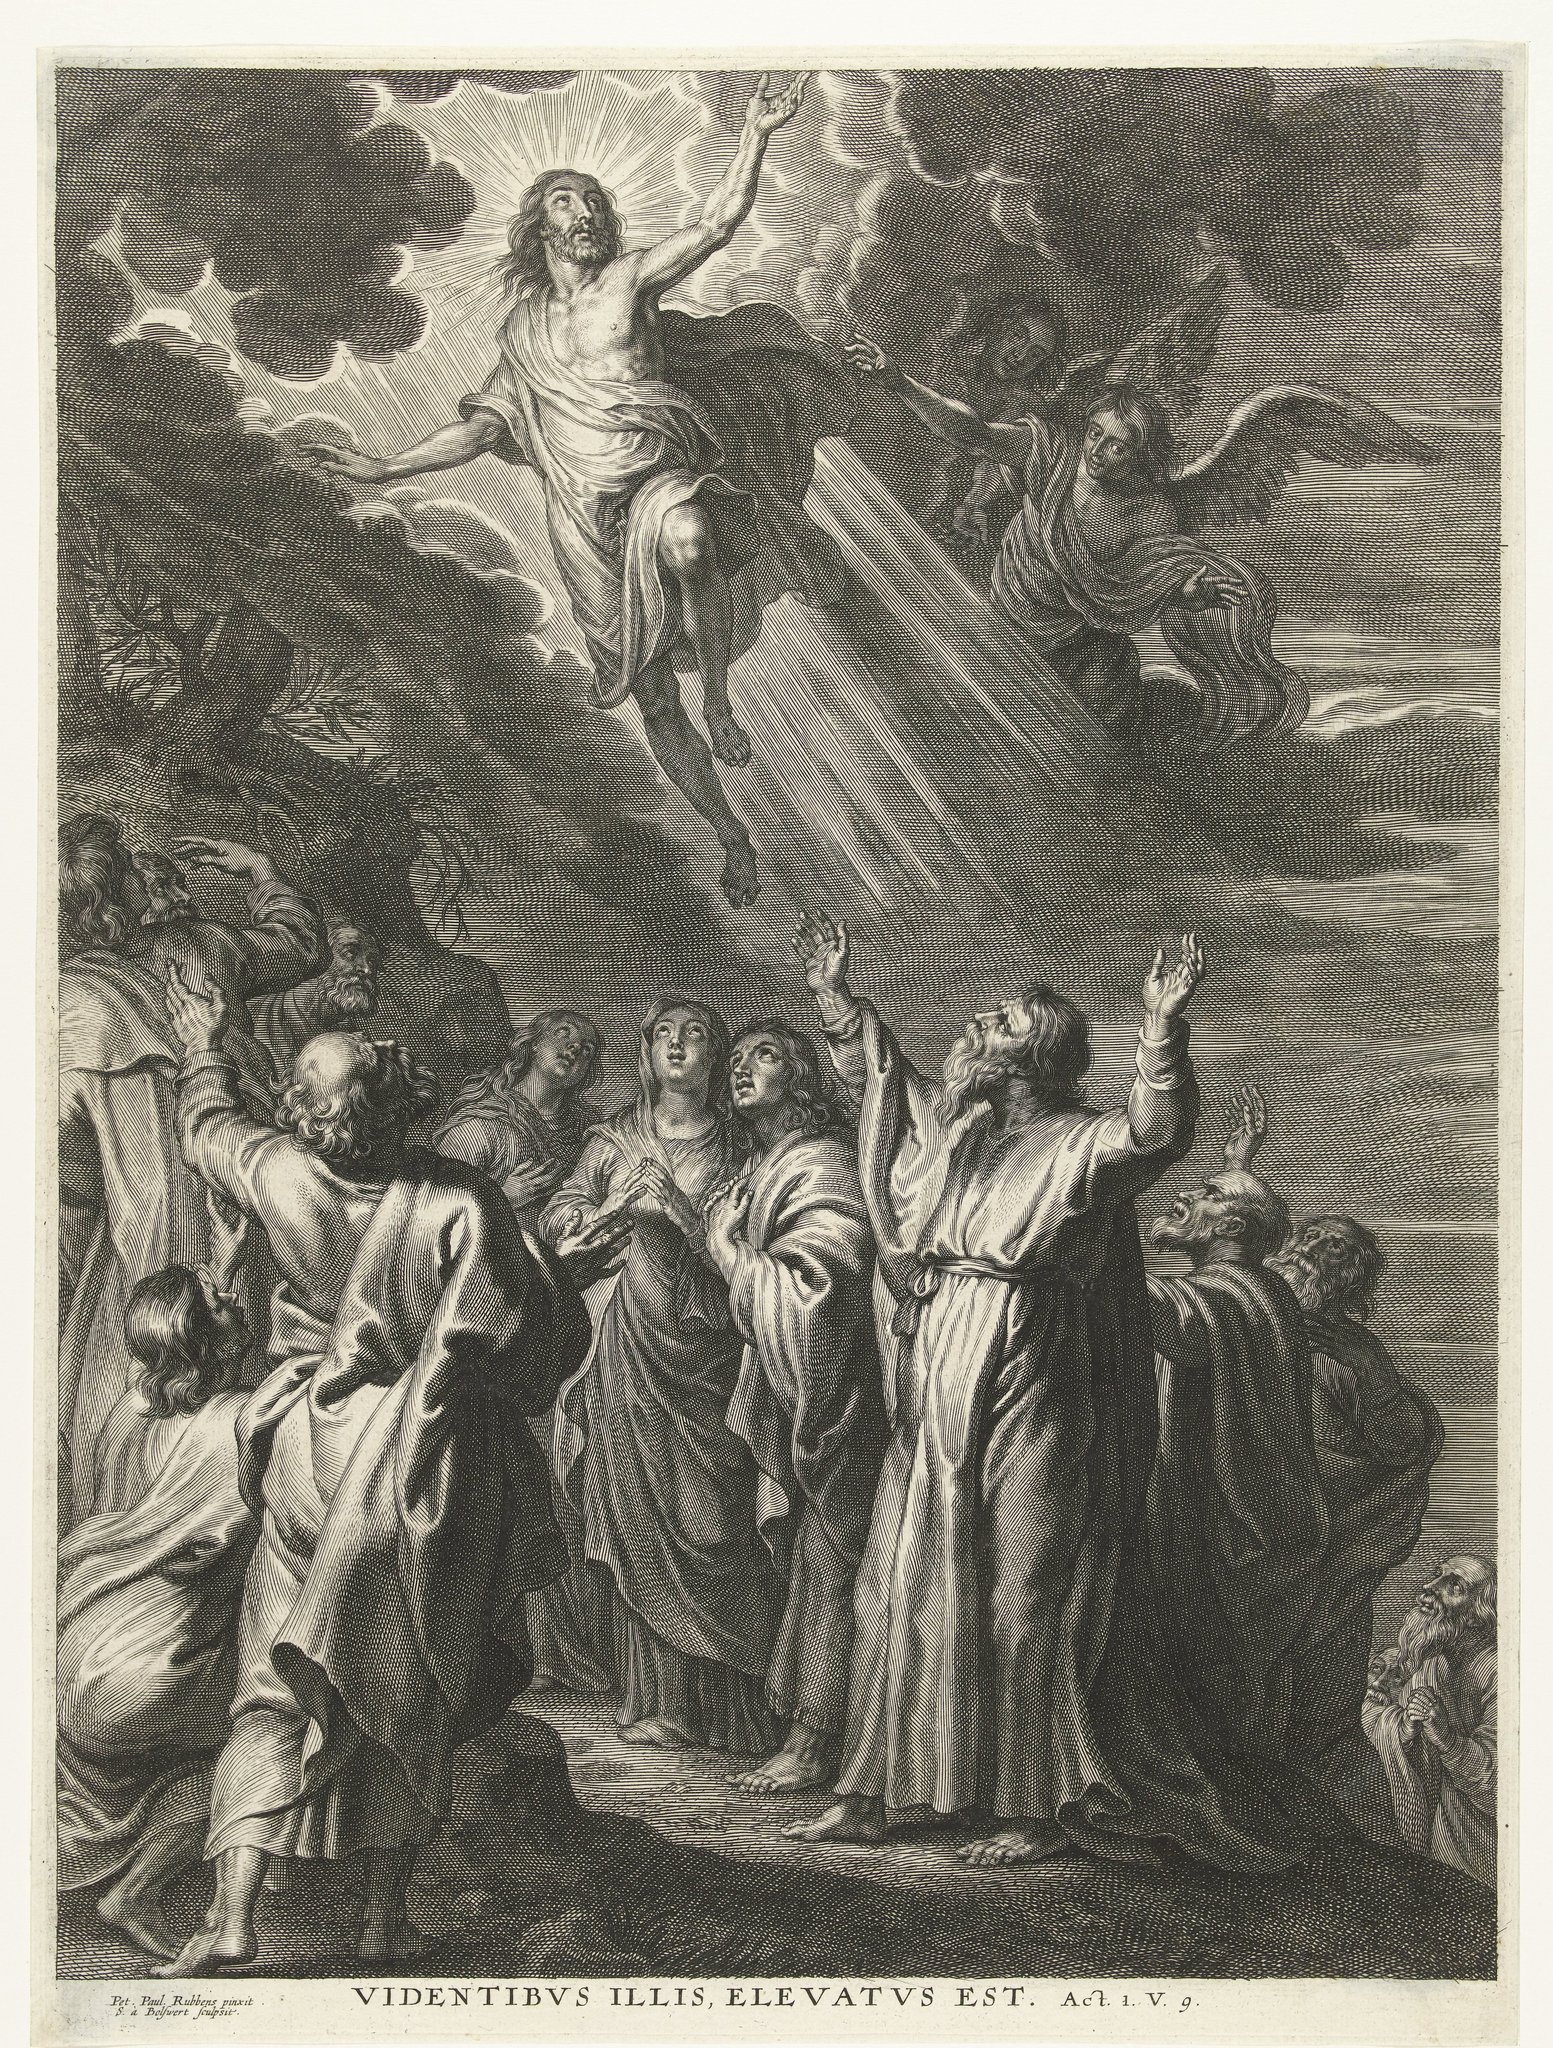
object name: print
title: Hemelvaart van Christus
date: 1596-1659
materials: paper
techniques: engraving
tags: christ ascends into heaven; apostles (and mary) beneath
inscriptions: collector's mark: Lugt 240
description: Hemelvaart van Christus in aanwezigheid van Maria en Johannes en de apostelen. Onder citaat Handelingen 1, vers 9.